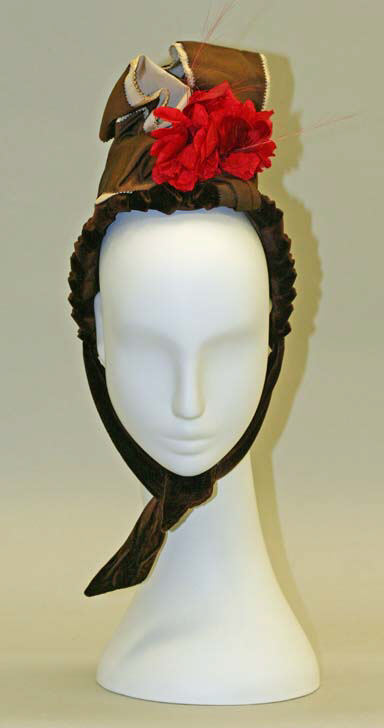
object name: bonnet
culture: american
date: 1880